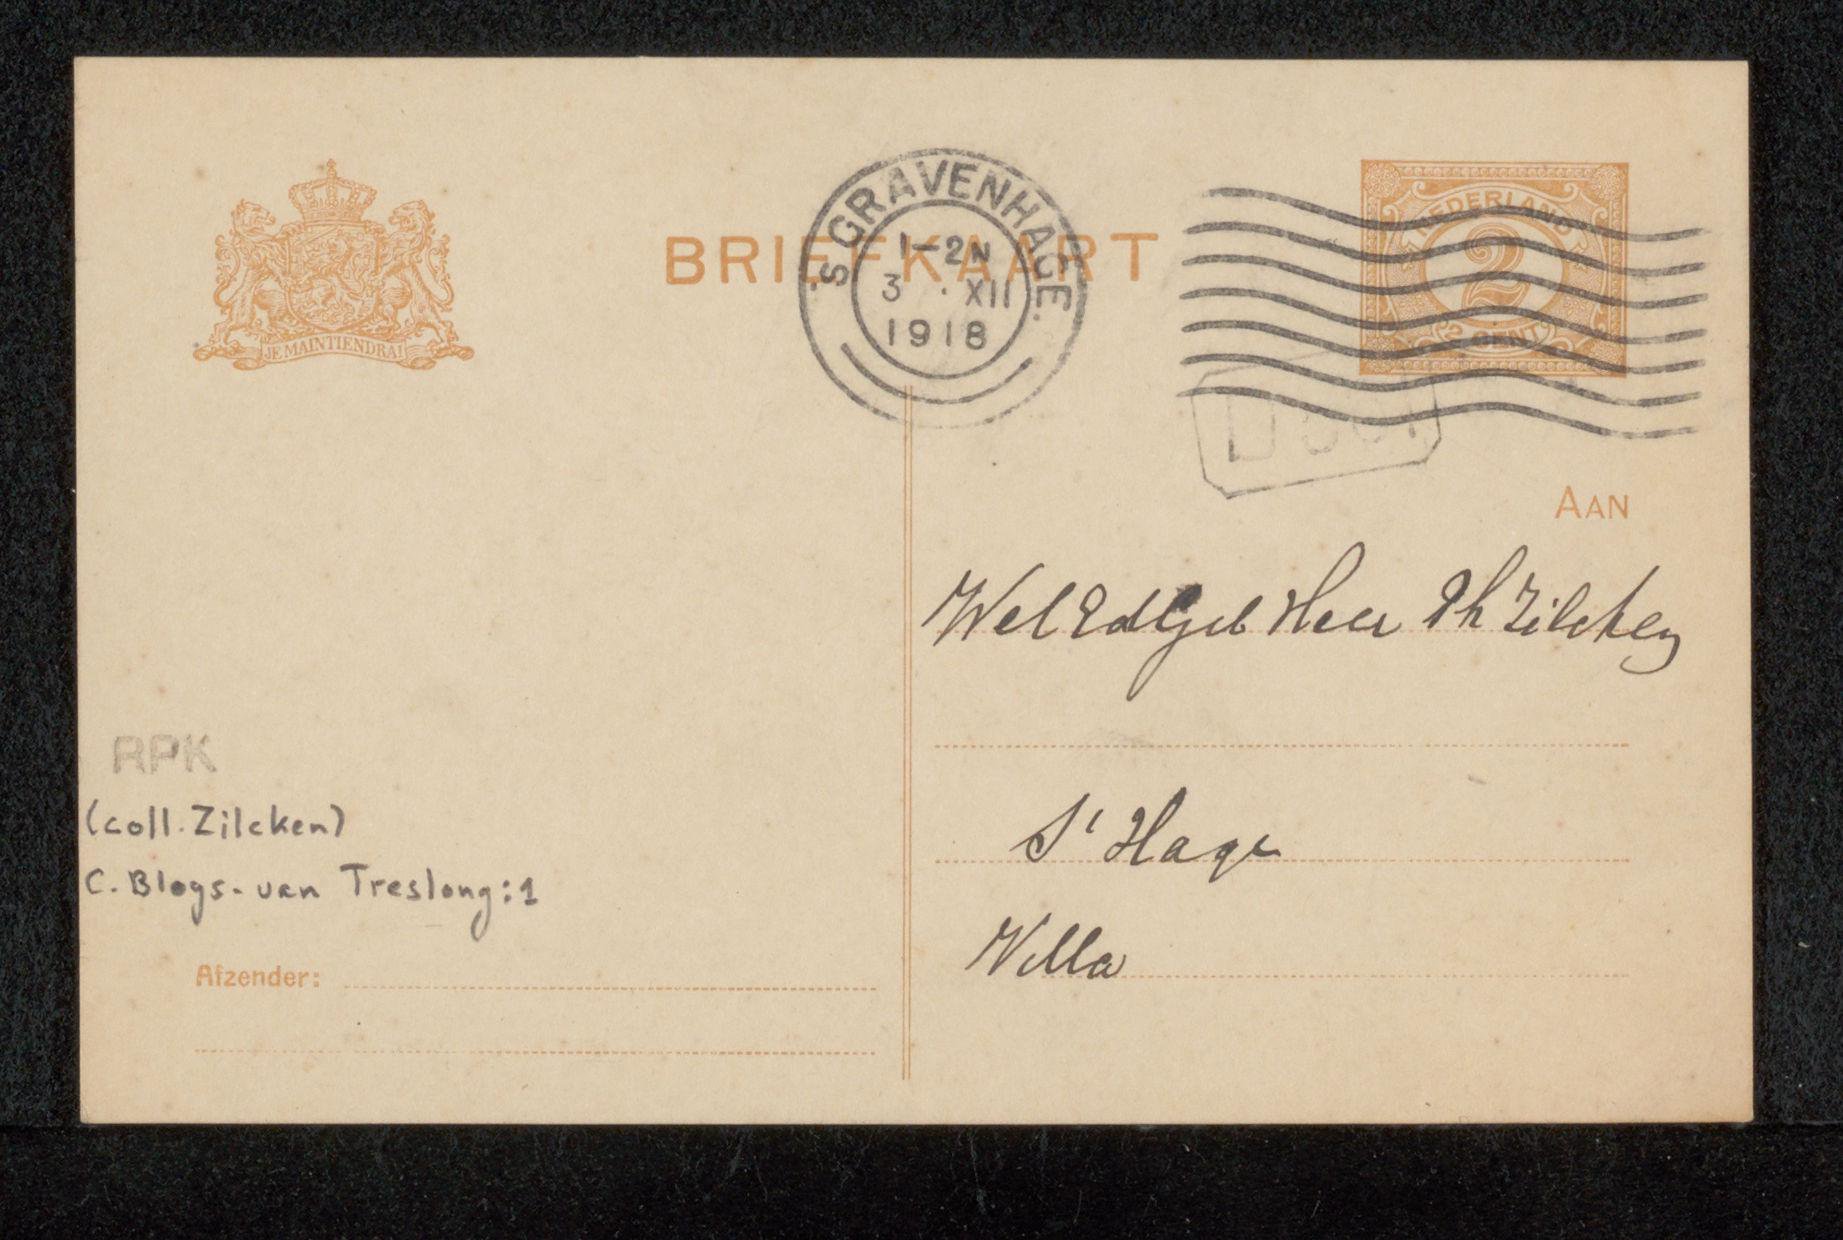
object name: postcard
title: Briefkaart aan Philip Zilcken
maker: c. bloys van treslong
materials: cardboard, ink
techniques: pen, writing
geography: the hague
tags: the hague, painter, philip zilcken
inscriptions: collector's mark: ‘RPK’